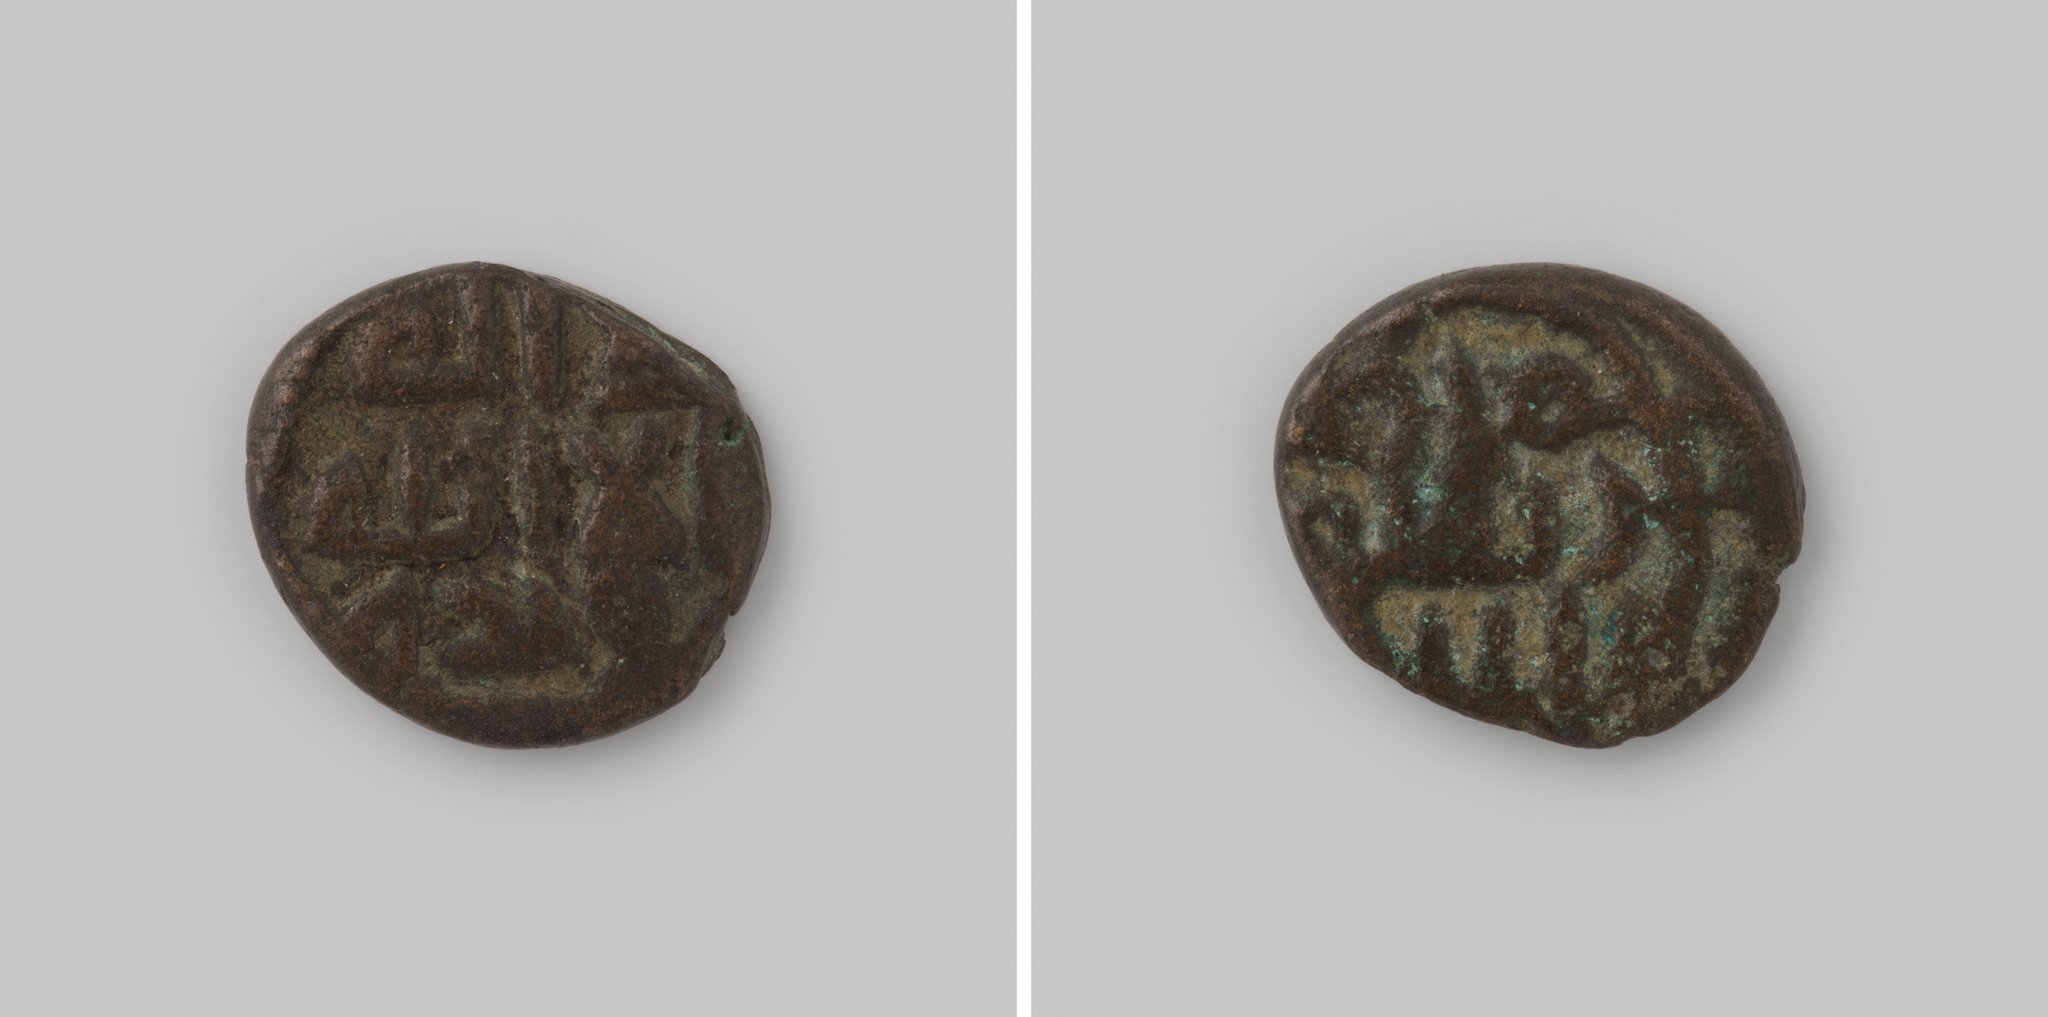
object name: coin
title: Omajaden, kalief Abd el-Melik, 65-86 AH [=685-705], fels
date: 685-705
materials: copper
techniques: striking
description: Koperen munt. Voorzijde: in drie regels opschrift in Arabische lettertekenss. Keerzijde: binnen cirkel in drie regels opschrift in Arabische lettertekens.